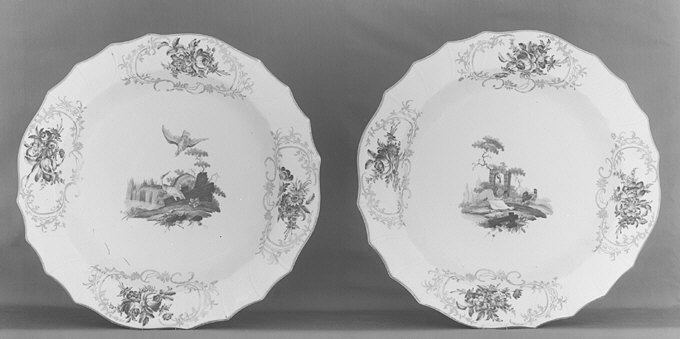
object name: plate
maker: tournai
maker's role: factory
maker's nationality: belgian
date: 1776-1781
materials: soft paste porcelain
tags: birds,flowers